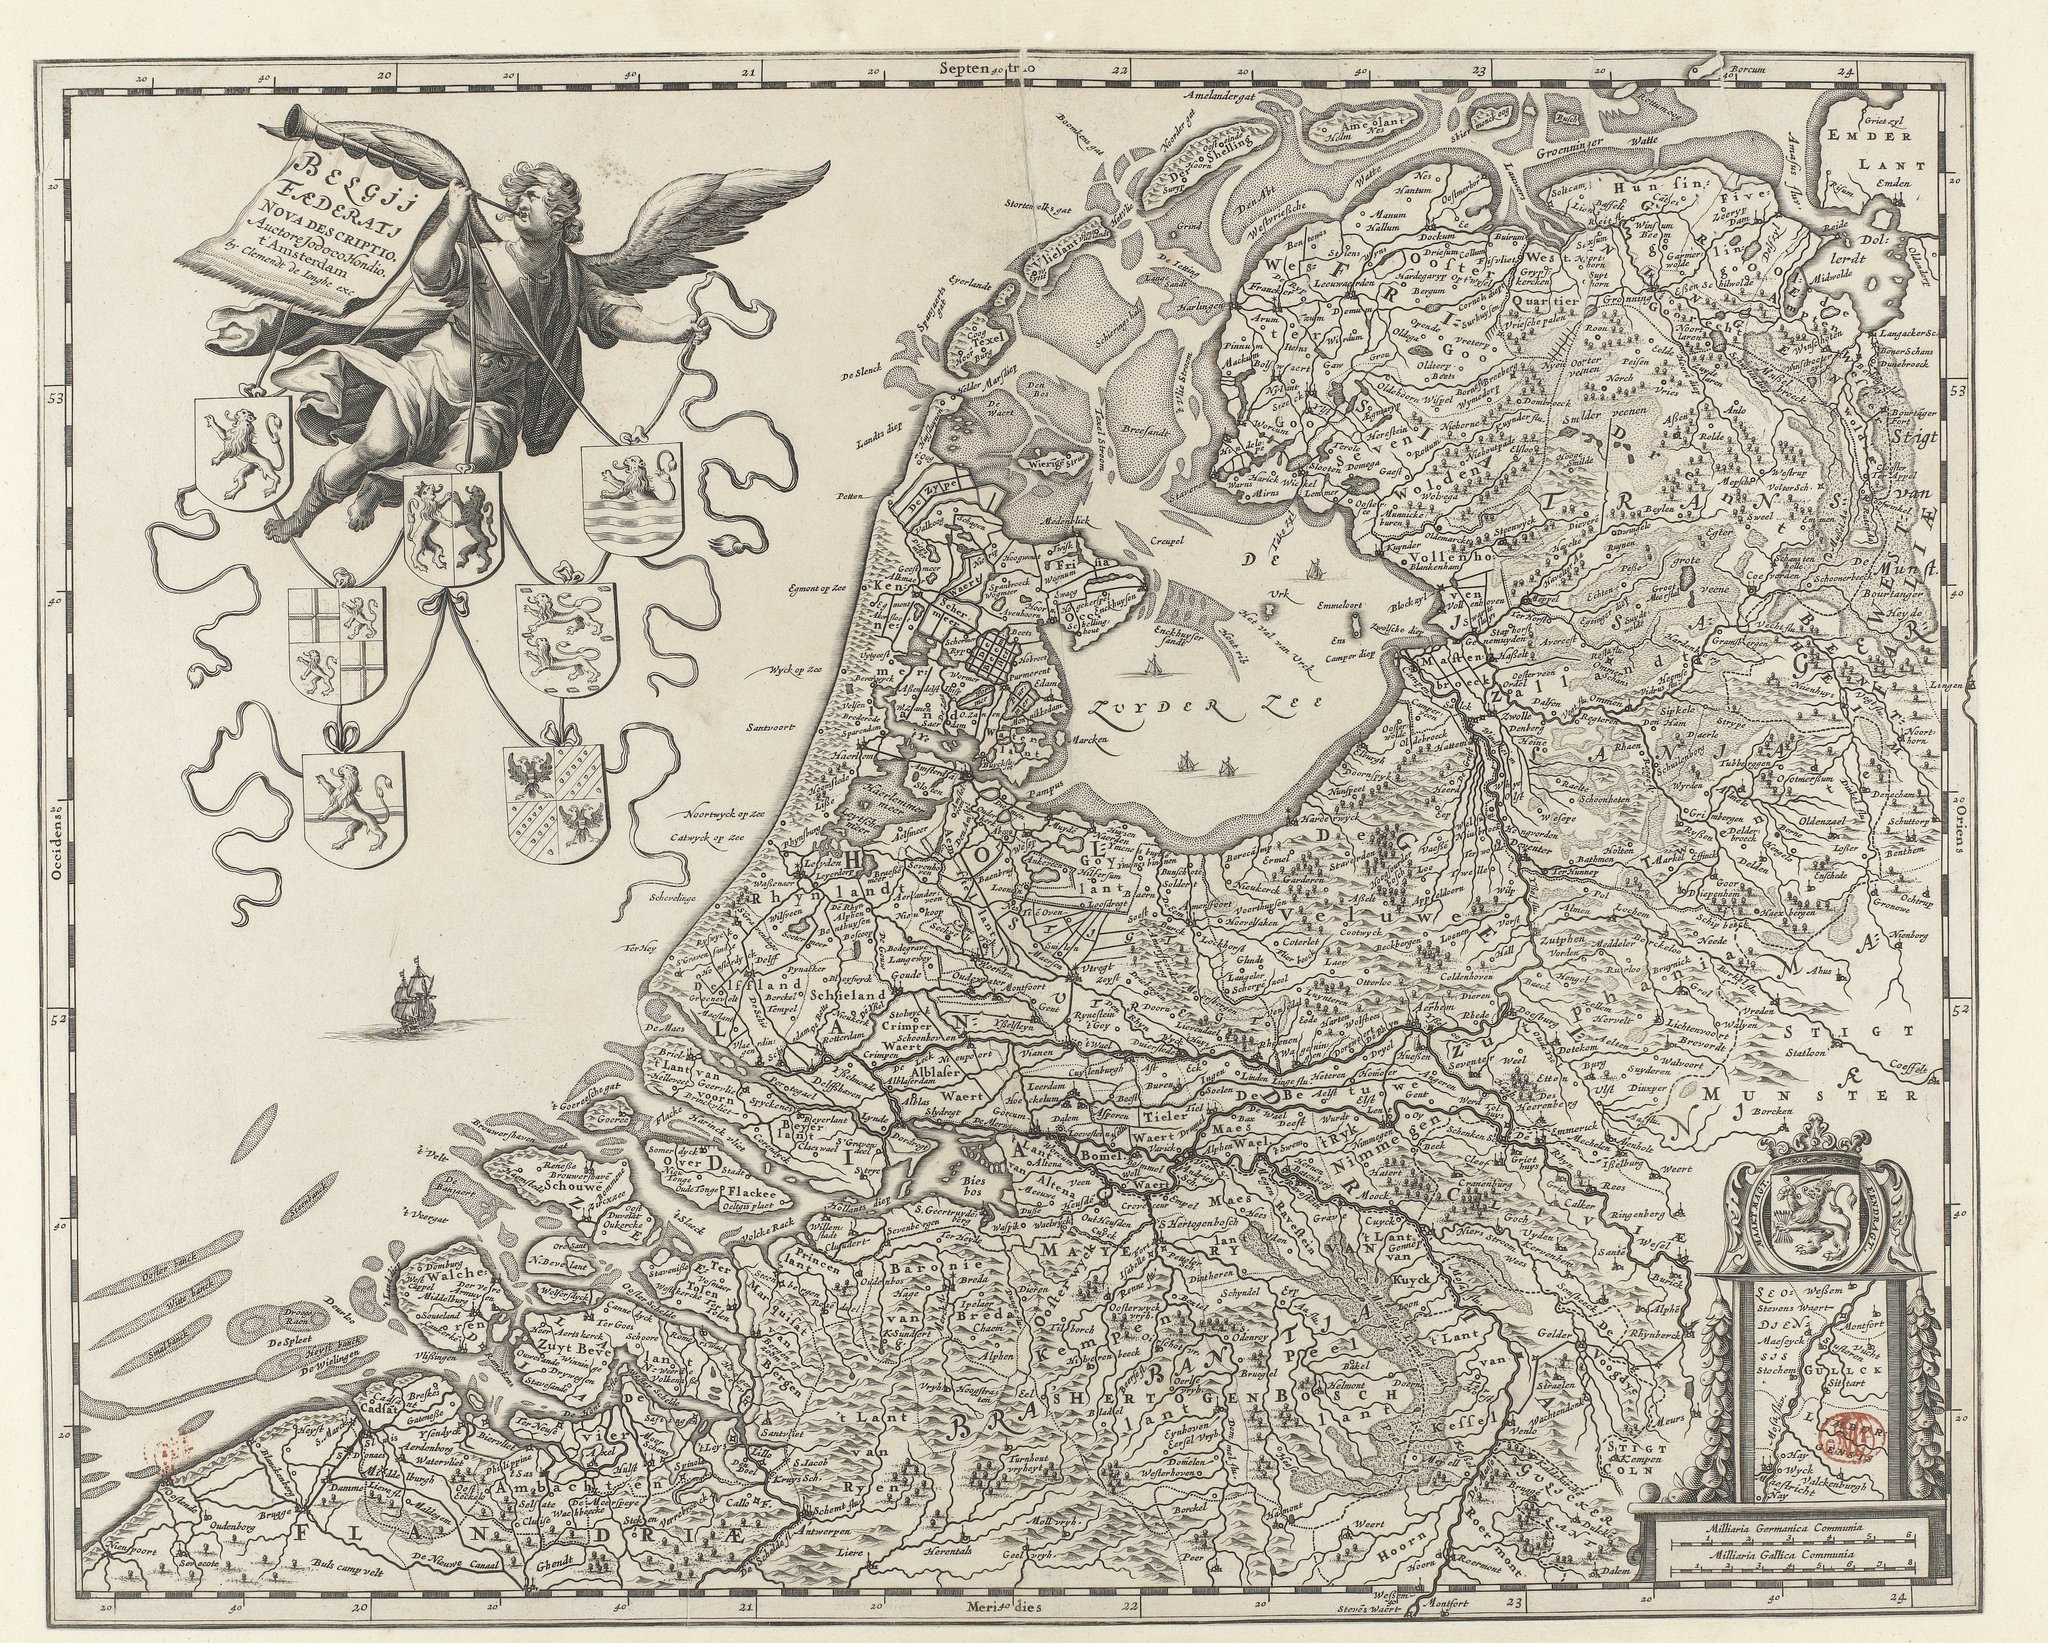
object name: print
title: Belgii Faederati Nova Descriptio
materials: paper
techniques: engraving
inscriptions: stamp: ‘Atlas Ottens’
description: Kaart een van de Nederlanden. Linksboven een engel met bazuin waarop de titel 'Belgii Faederati Nova Descriptio'en naam van maker en uitgever: Auctore Jodoco Hondio / by Clemendt de Jonghe exc. Aan een koord in zijn hand hangen de wapens van de 7 provincien.